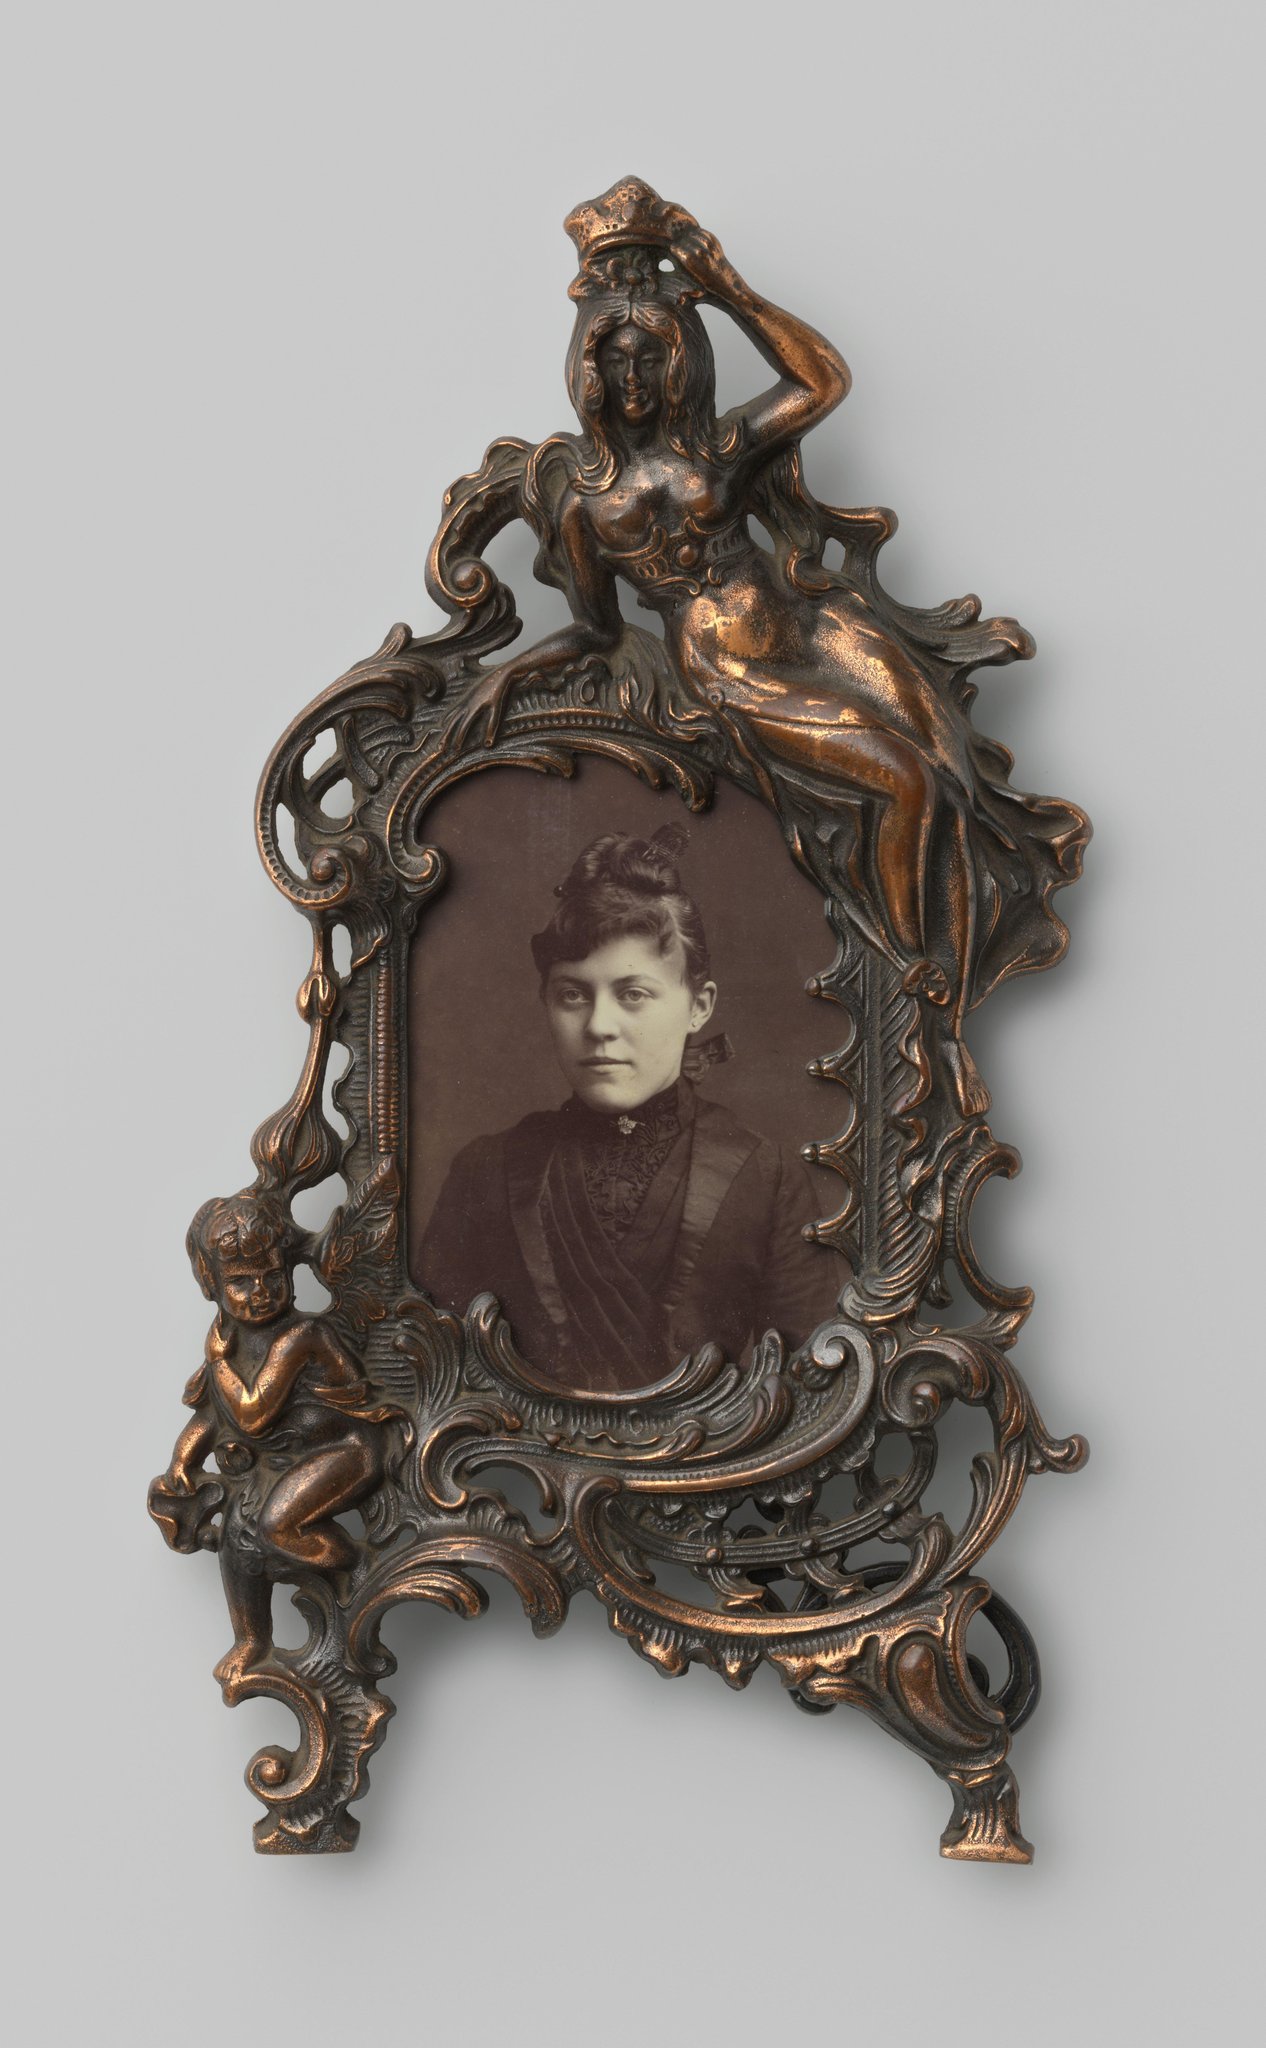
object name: cabinet photograph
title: Portret van een onbekende jonge vrouw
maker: Anonymous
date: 1860-1920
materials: paper, cardboard, metal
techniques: collodion silver print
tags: adult woman, anonymous historical person portrayed